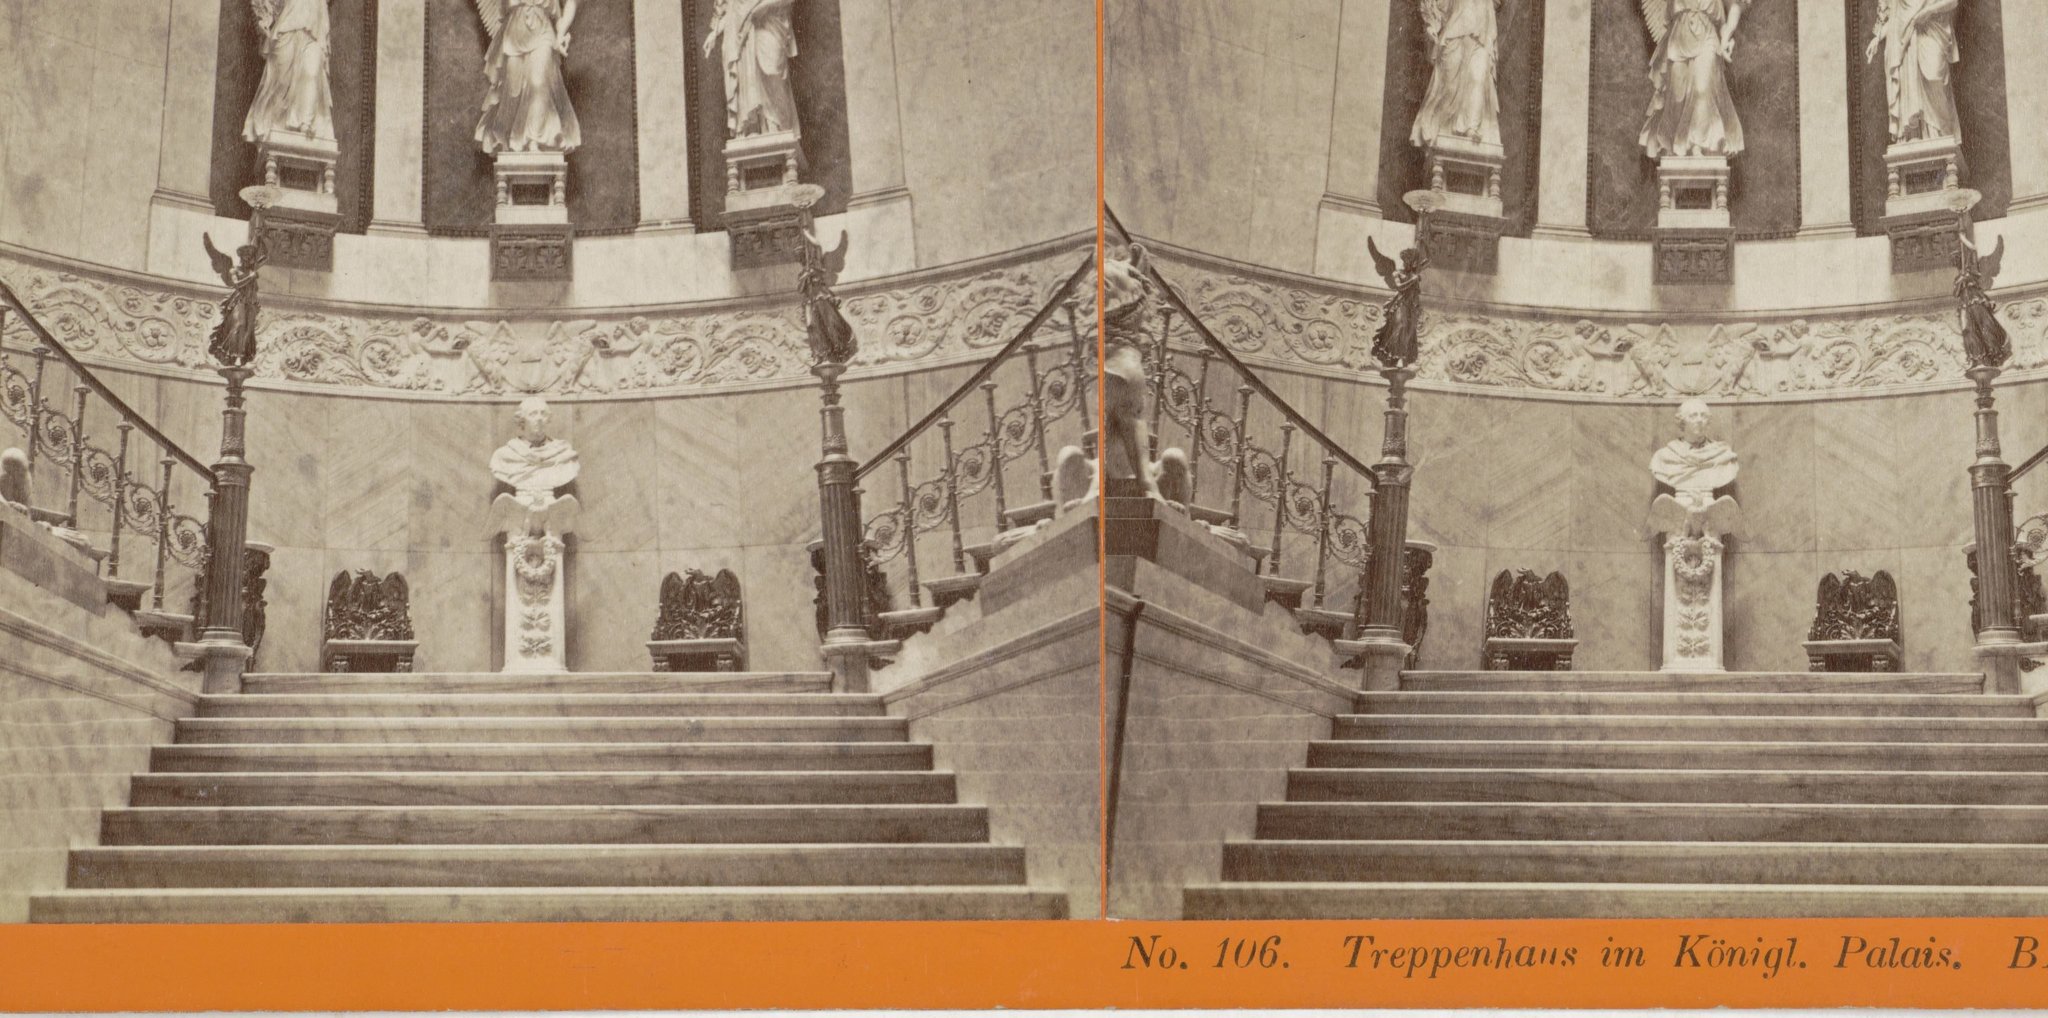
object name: stereograph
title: Treppenhaus im Königl. Palais. Berlin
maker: johann friedrich stiehm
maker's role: fotograaf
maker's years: 1826-1902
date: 1868-1871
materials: cardboard, paper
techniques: albumen print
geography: berlin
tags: palace, staircase, berlin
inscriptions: number: ‘No. 106’